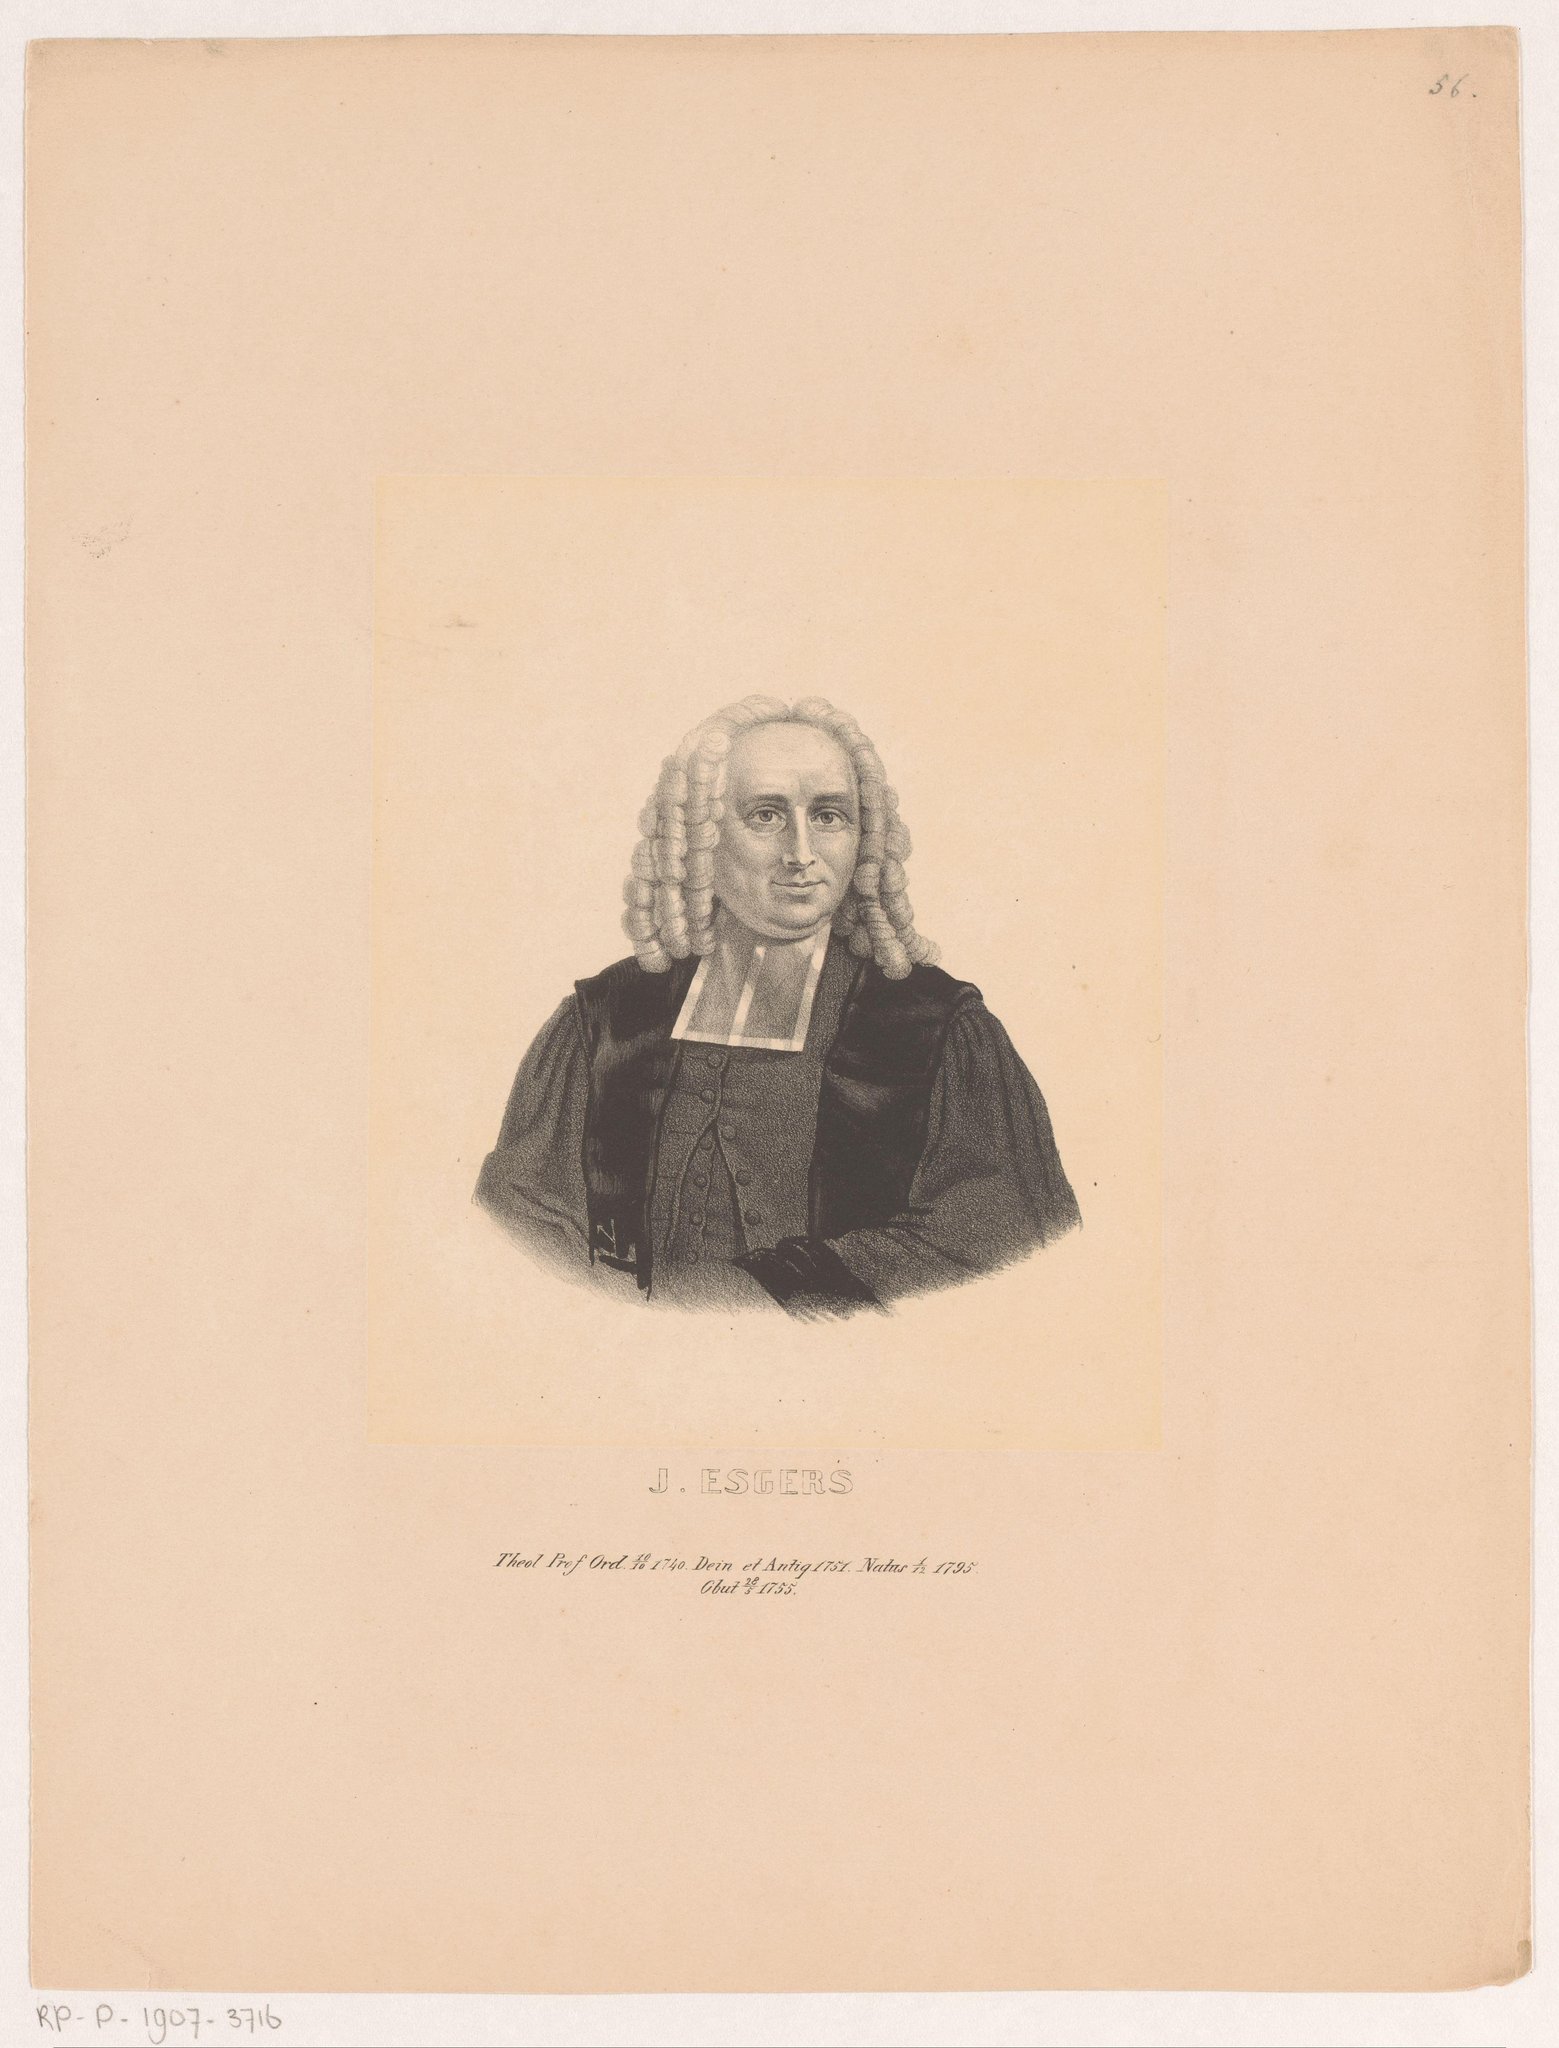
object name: print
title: Portret van Johannes Esgers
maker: leendert springer (i)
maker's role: draughtsman, painter, print maker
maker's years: 1789-1871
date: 1850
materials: paper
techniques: tone lithography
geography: leiden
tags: amsterdam, historical persons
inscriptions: collector's mark: Lugt 2228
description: Prent uit: Springer, Leendert. Galerij van hoogleeraren aan de Hoogeschool te Leijden, naar de oorspronkelijke afbeeldsels op de Senaat-zaal aldaar berustende. Leiden: Springer, Leendert., s.a. [circa 1850].